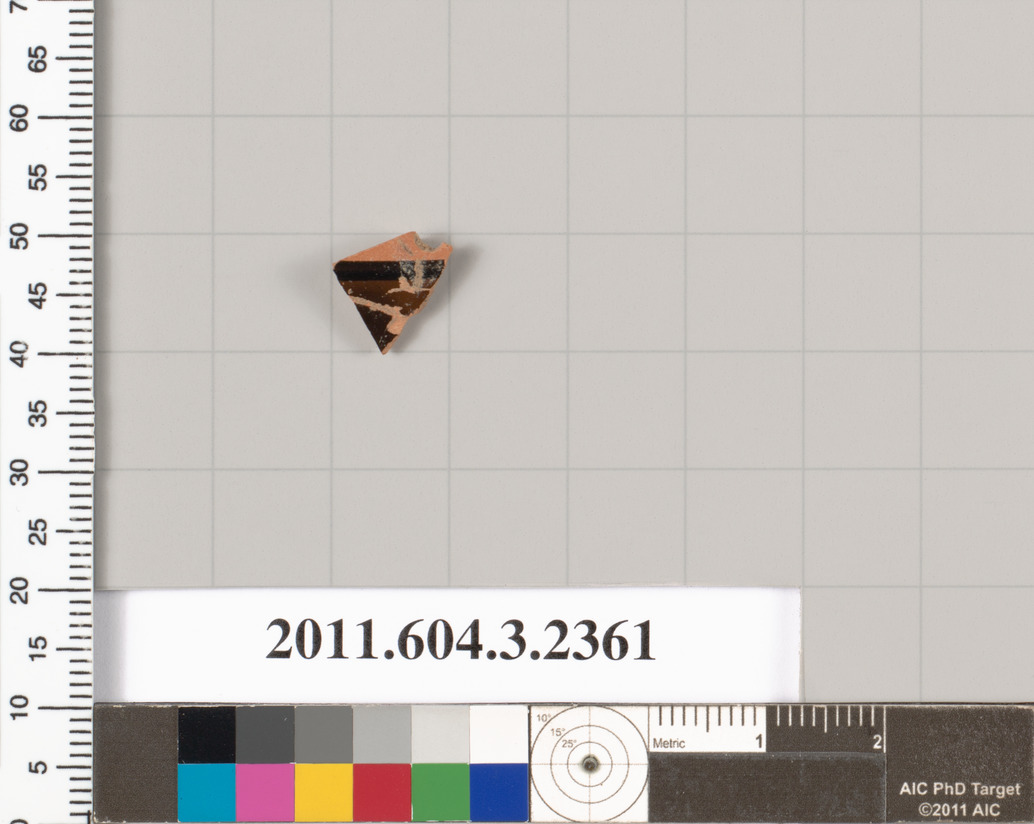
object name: kylix fragment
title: Terracotta fragment of a kylix: eye-cup (drinking cup)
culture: greek, attic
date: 540-510 BCE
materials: terracotta